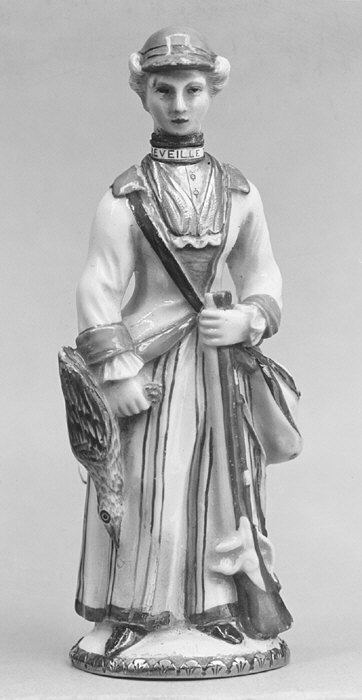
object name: scent bottle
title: Scent bottle in the form of a huntress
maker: meissen manufactory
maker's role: manufactory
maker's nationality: german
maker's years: 1710-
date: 1740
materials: metal, porcelain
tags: birds,women